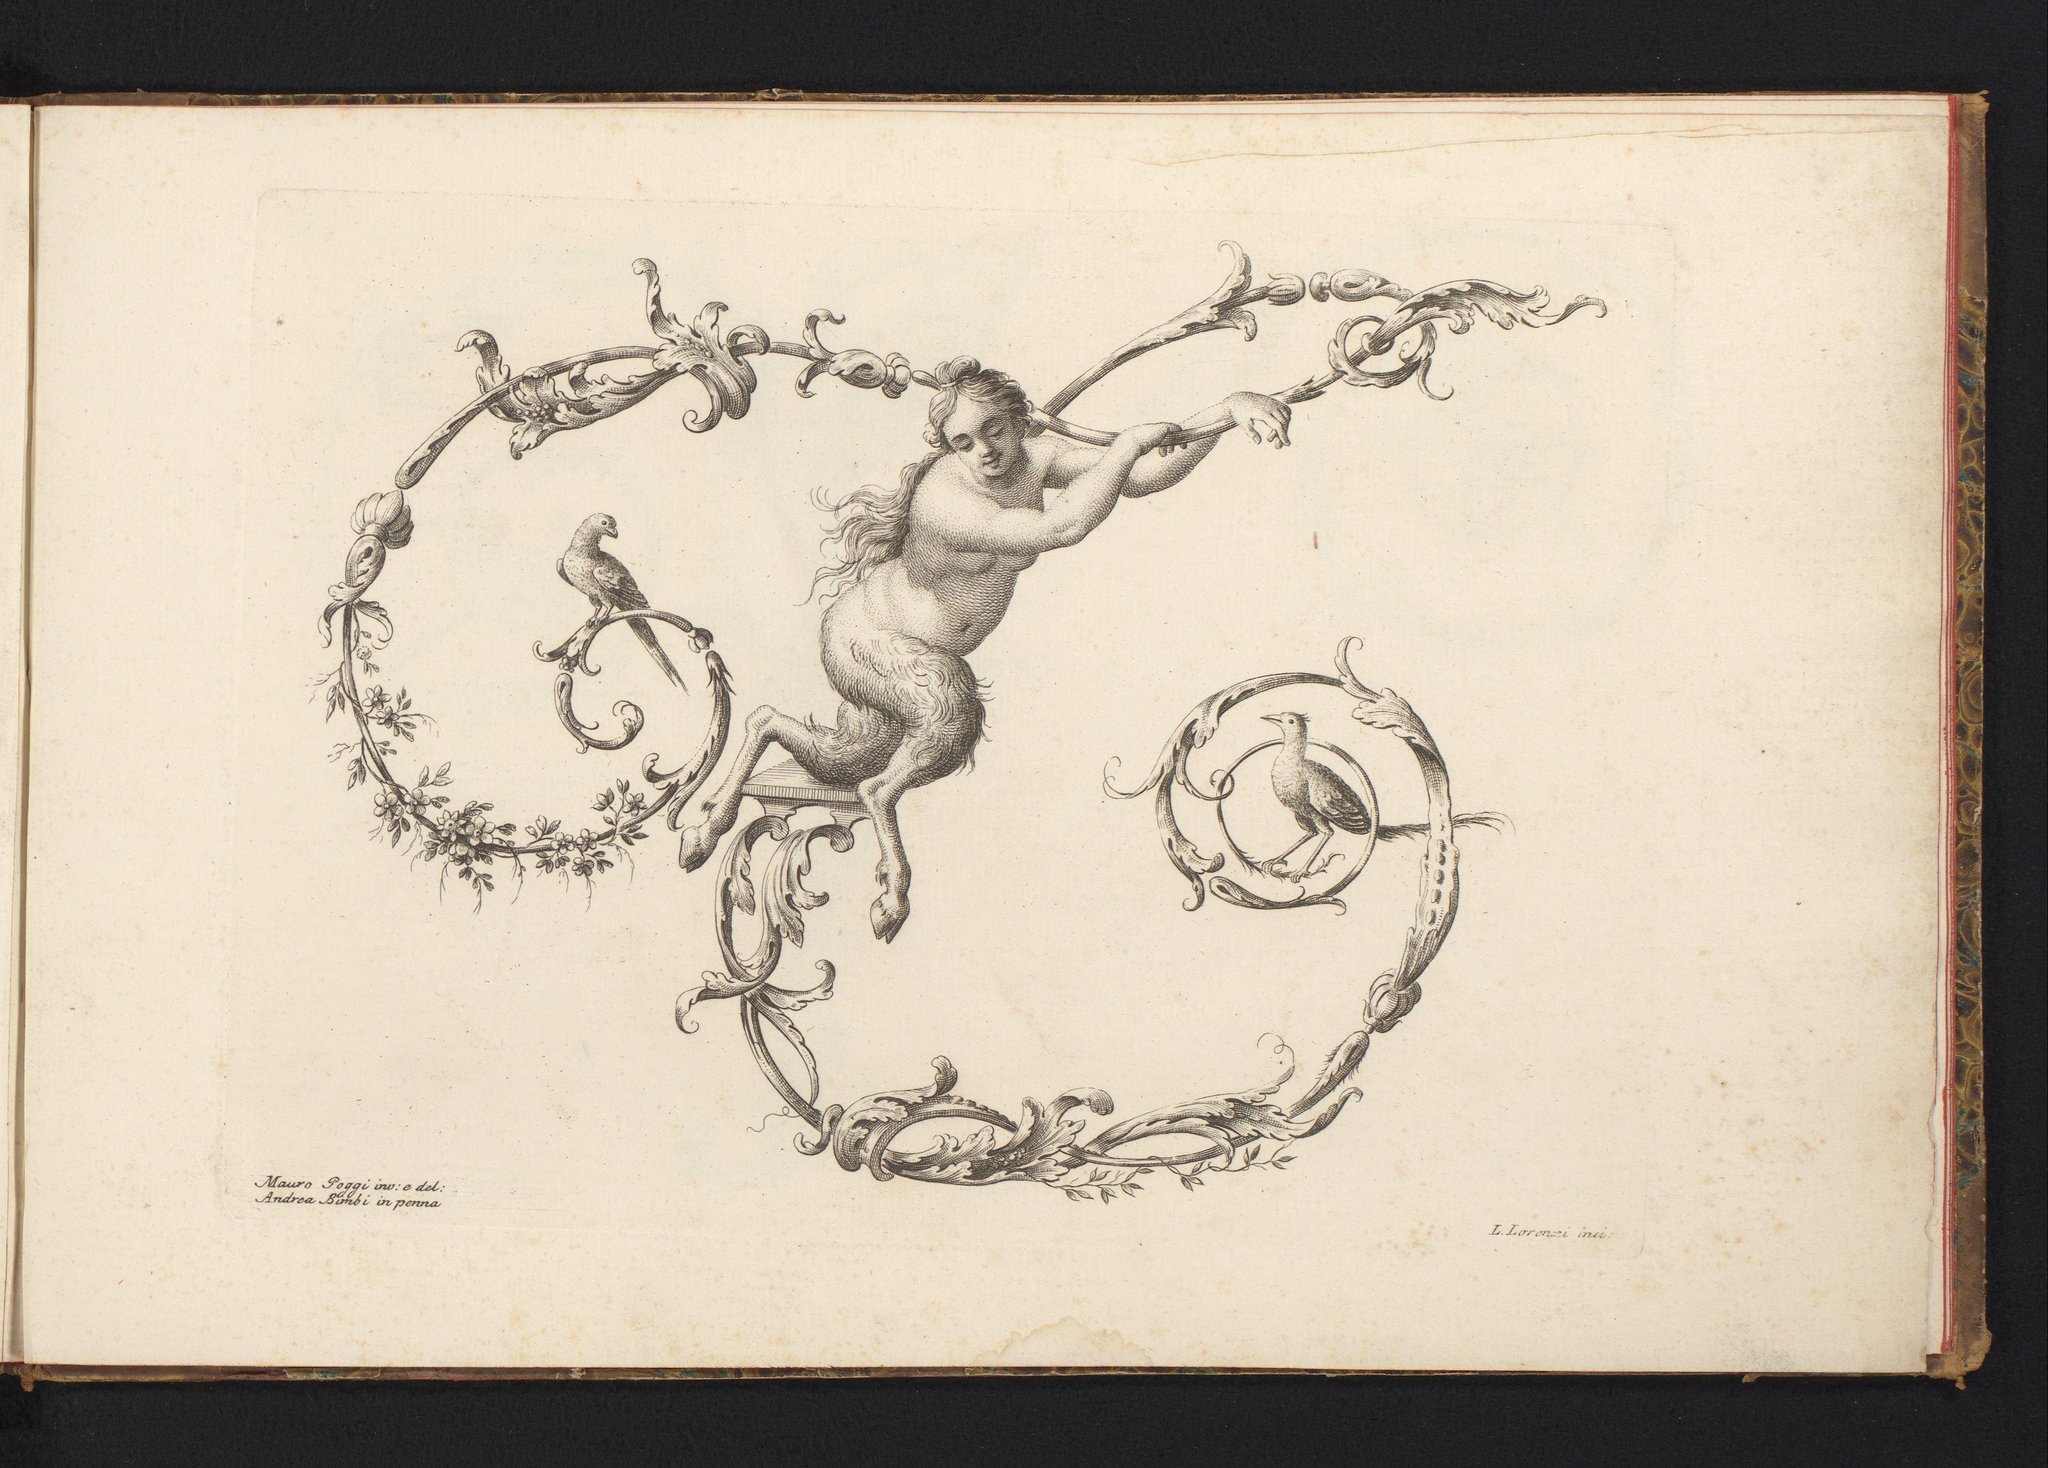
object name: print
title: Ornamenteel alfabet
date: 1745-1765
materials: paper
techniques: engraving, etching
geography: italy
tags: letters, alphabet, script, fancy letters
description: Ornamentele letter U, versierd met twee vogels en een vrouwelijke sater. Prent maakt deel uit van een album.